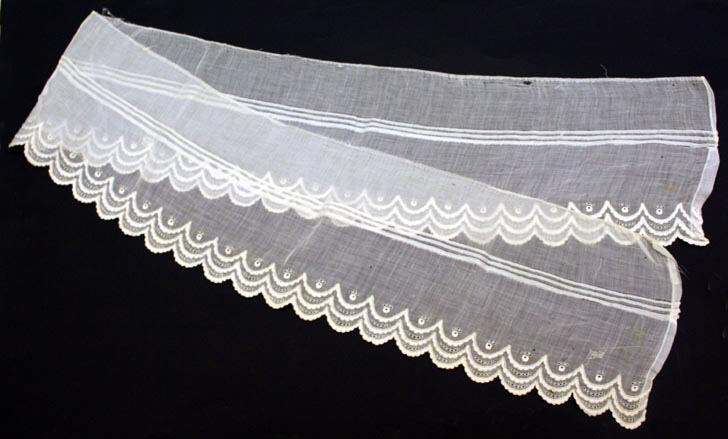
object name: cuff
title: Cuffs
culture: american or european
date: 1860-1869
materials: cotton